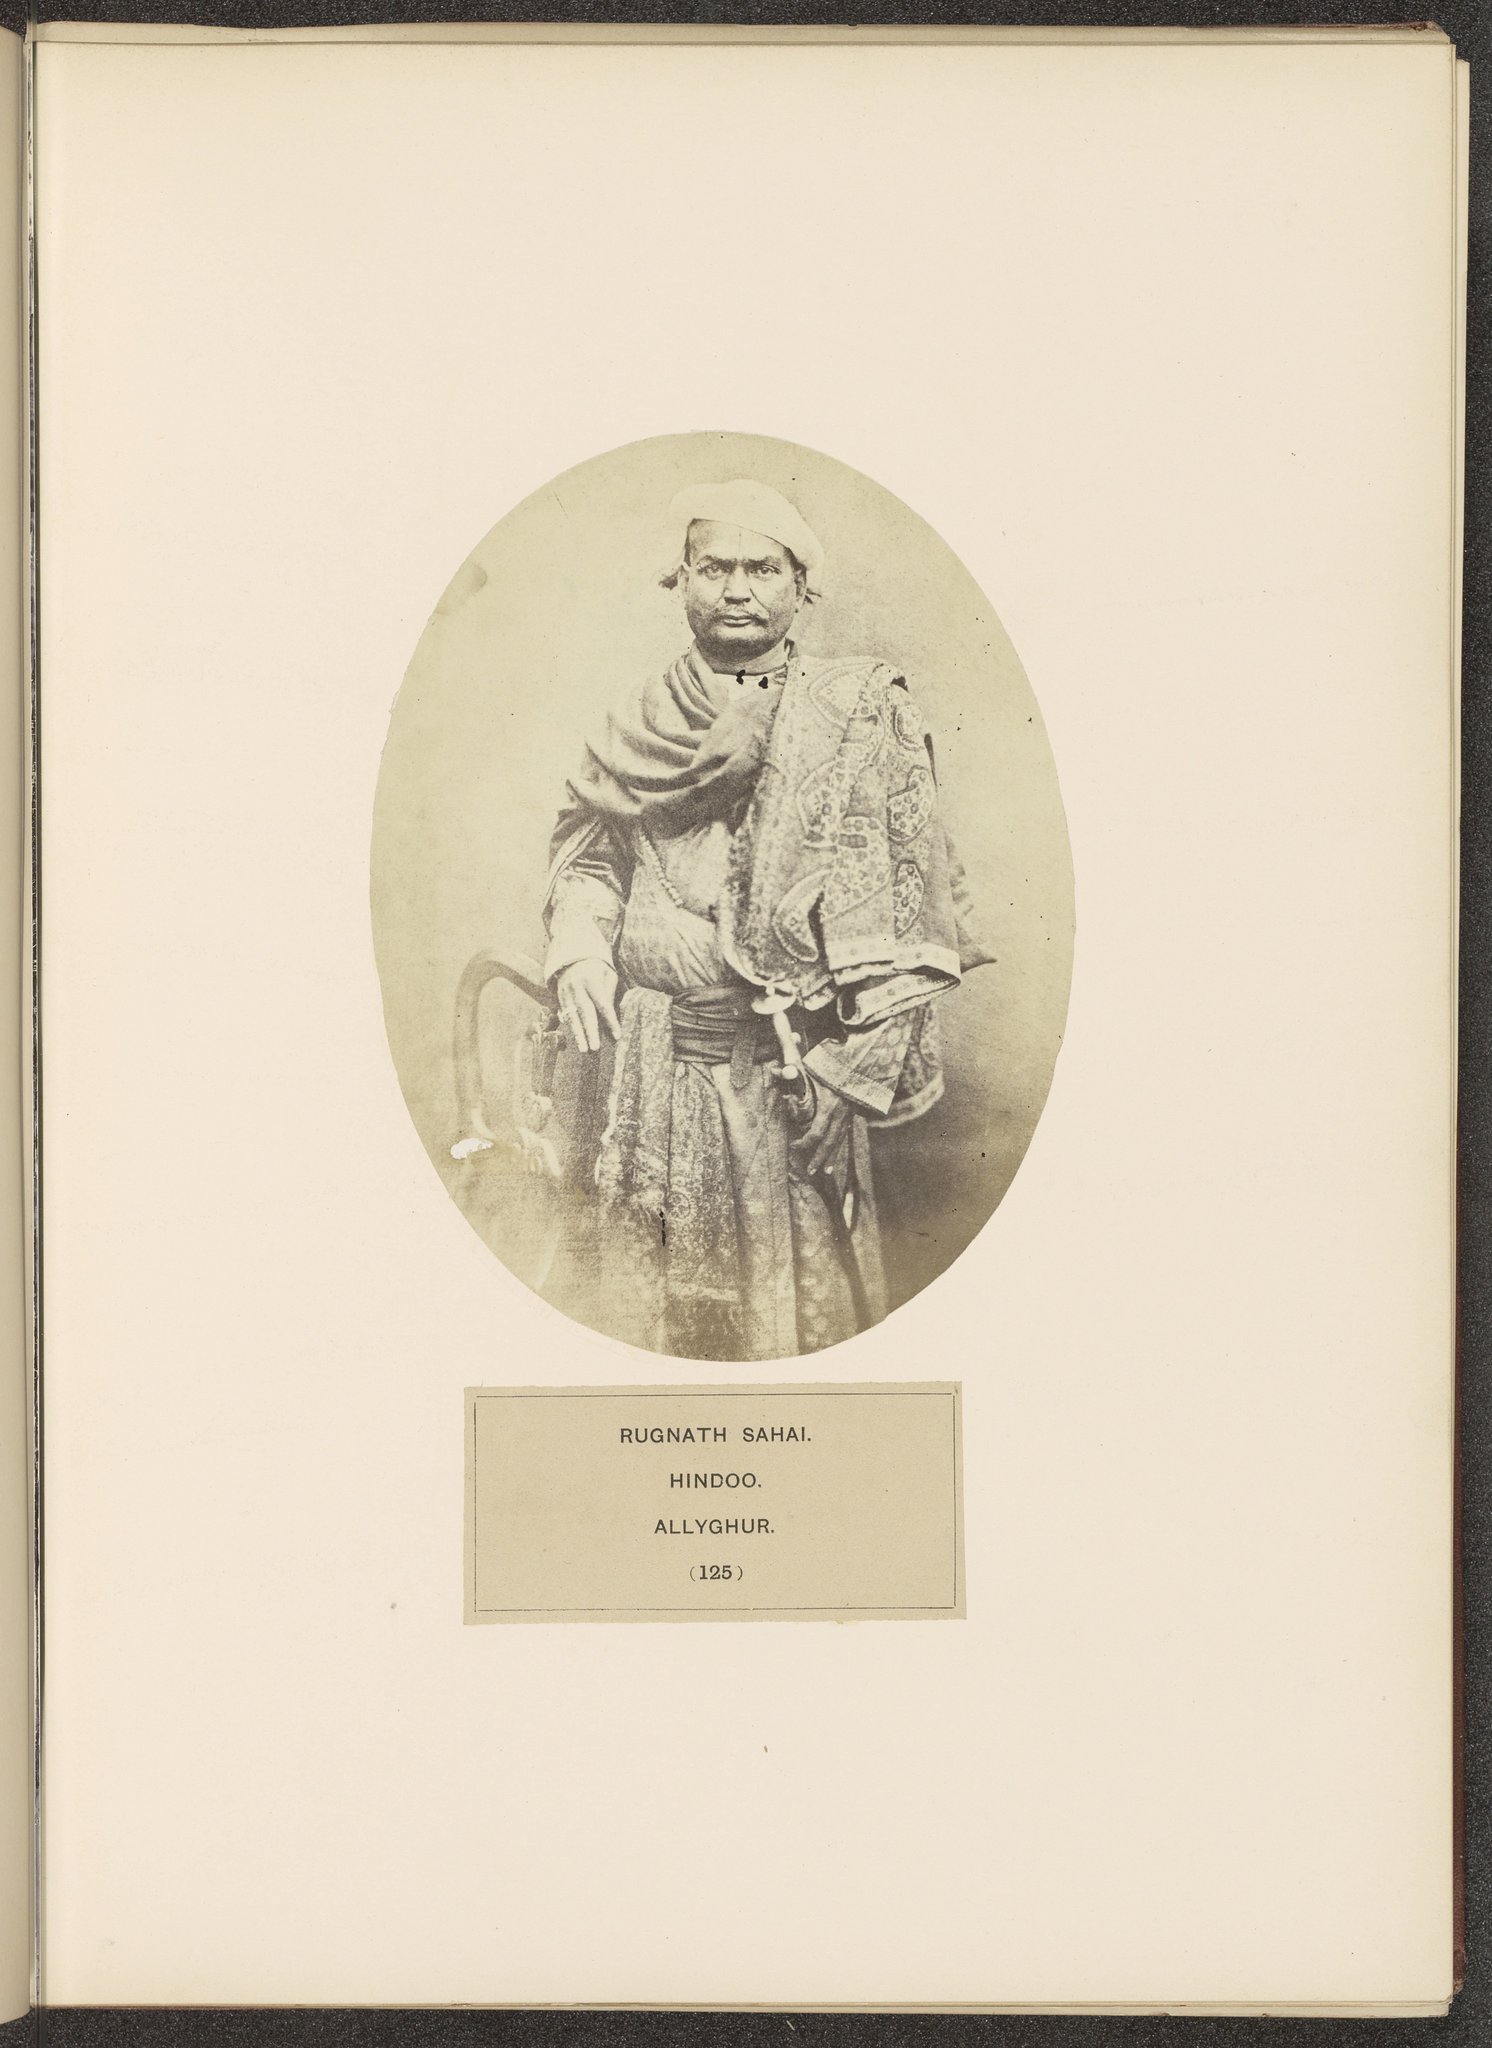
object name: page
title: Portrait of Rugnath Sahai from the Kayastha community of Aligrah, Uttar Pradesh, India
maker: Anonymous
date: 1858-1868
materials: photographic support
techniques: albumen print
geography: aligarh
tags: human races; peoples; nationalities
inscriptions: inscription: ‘RUGNATH SAHAI./ HINDOO./ ALLYGHUR.’, number: ‘(125)’